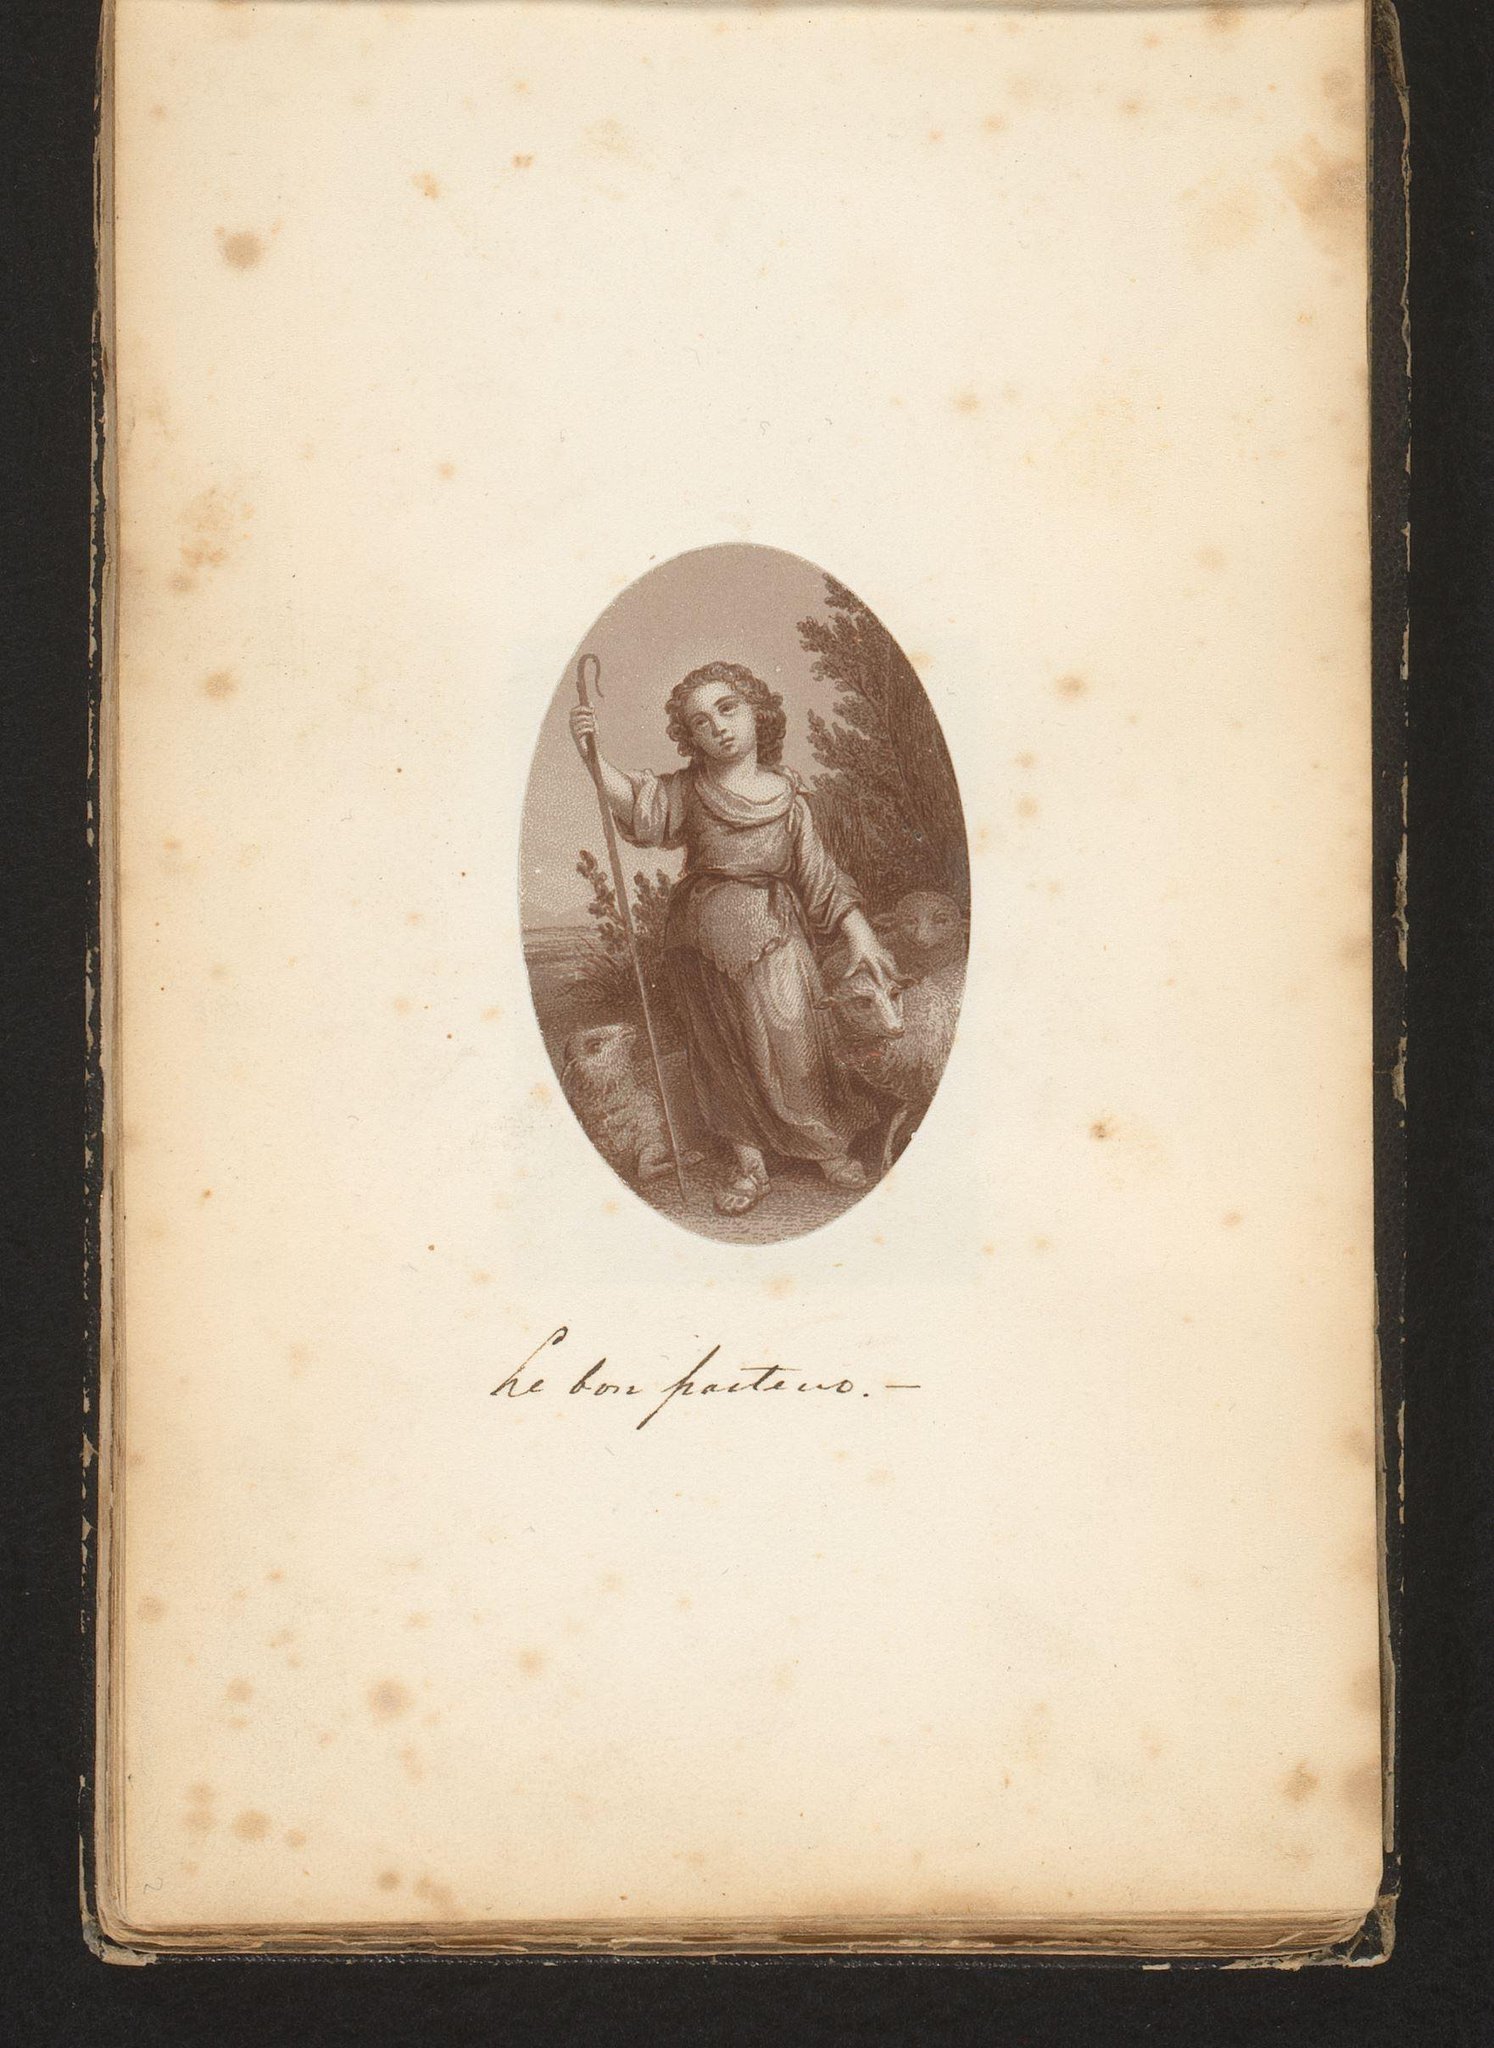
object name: album leaf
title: Fotoreproductie van een prent van een herder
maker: Anonymous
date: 1860-1900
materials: photographic support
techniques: collodion silver print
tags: herding, herdsman, herdswoman, shepherd, shepherdess, cowherd, etc., sheep, painting, drawing and the graphic arts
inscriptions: annotation: ‘Le bo[...]’